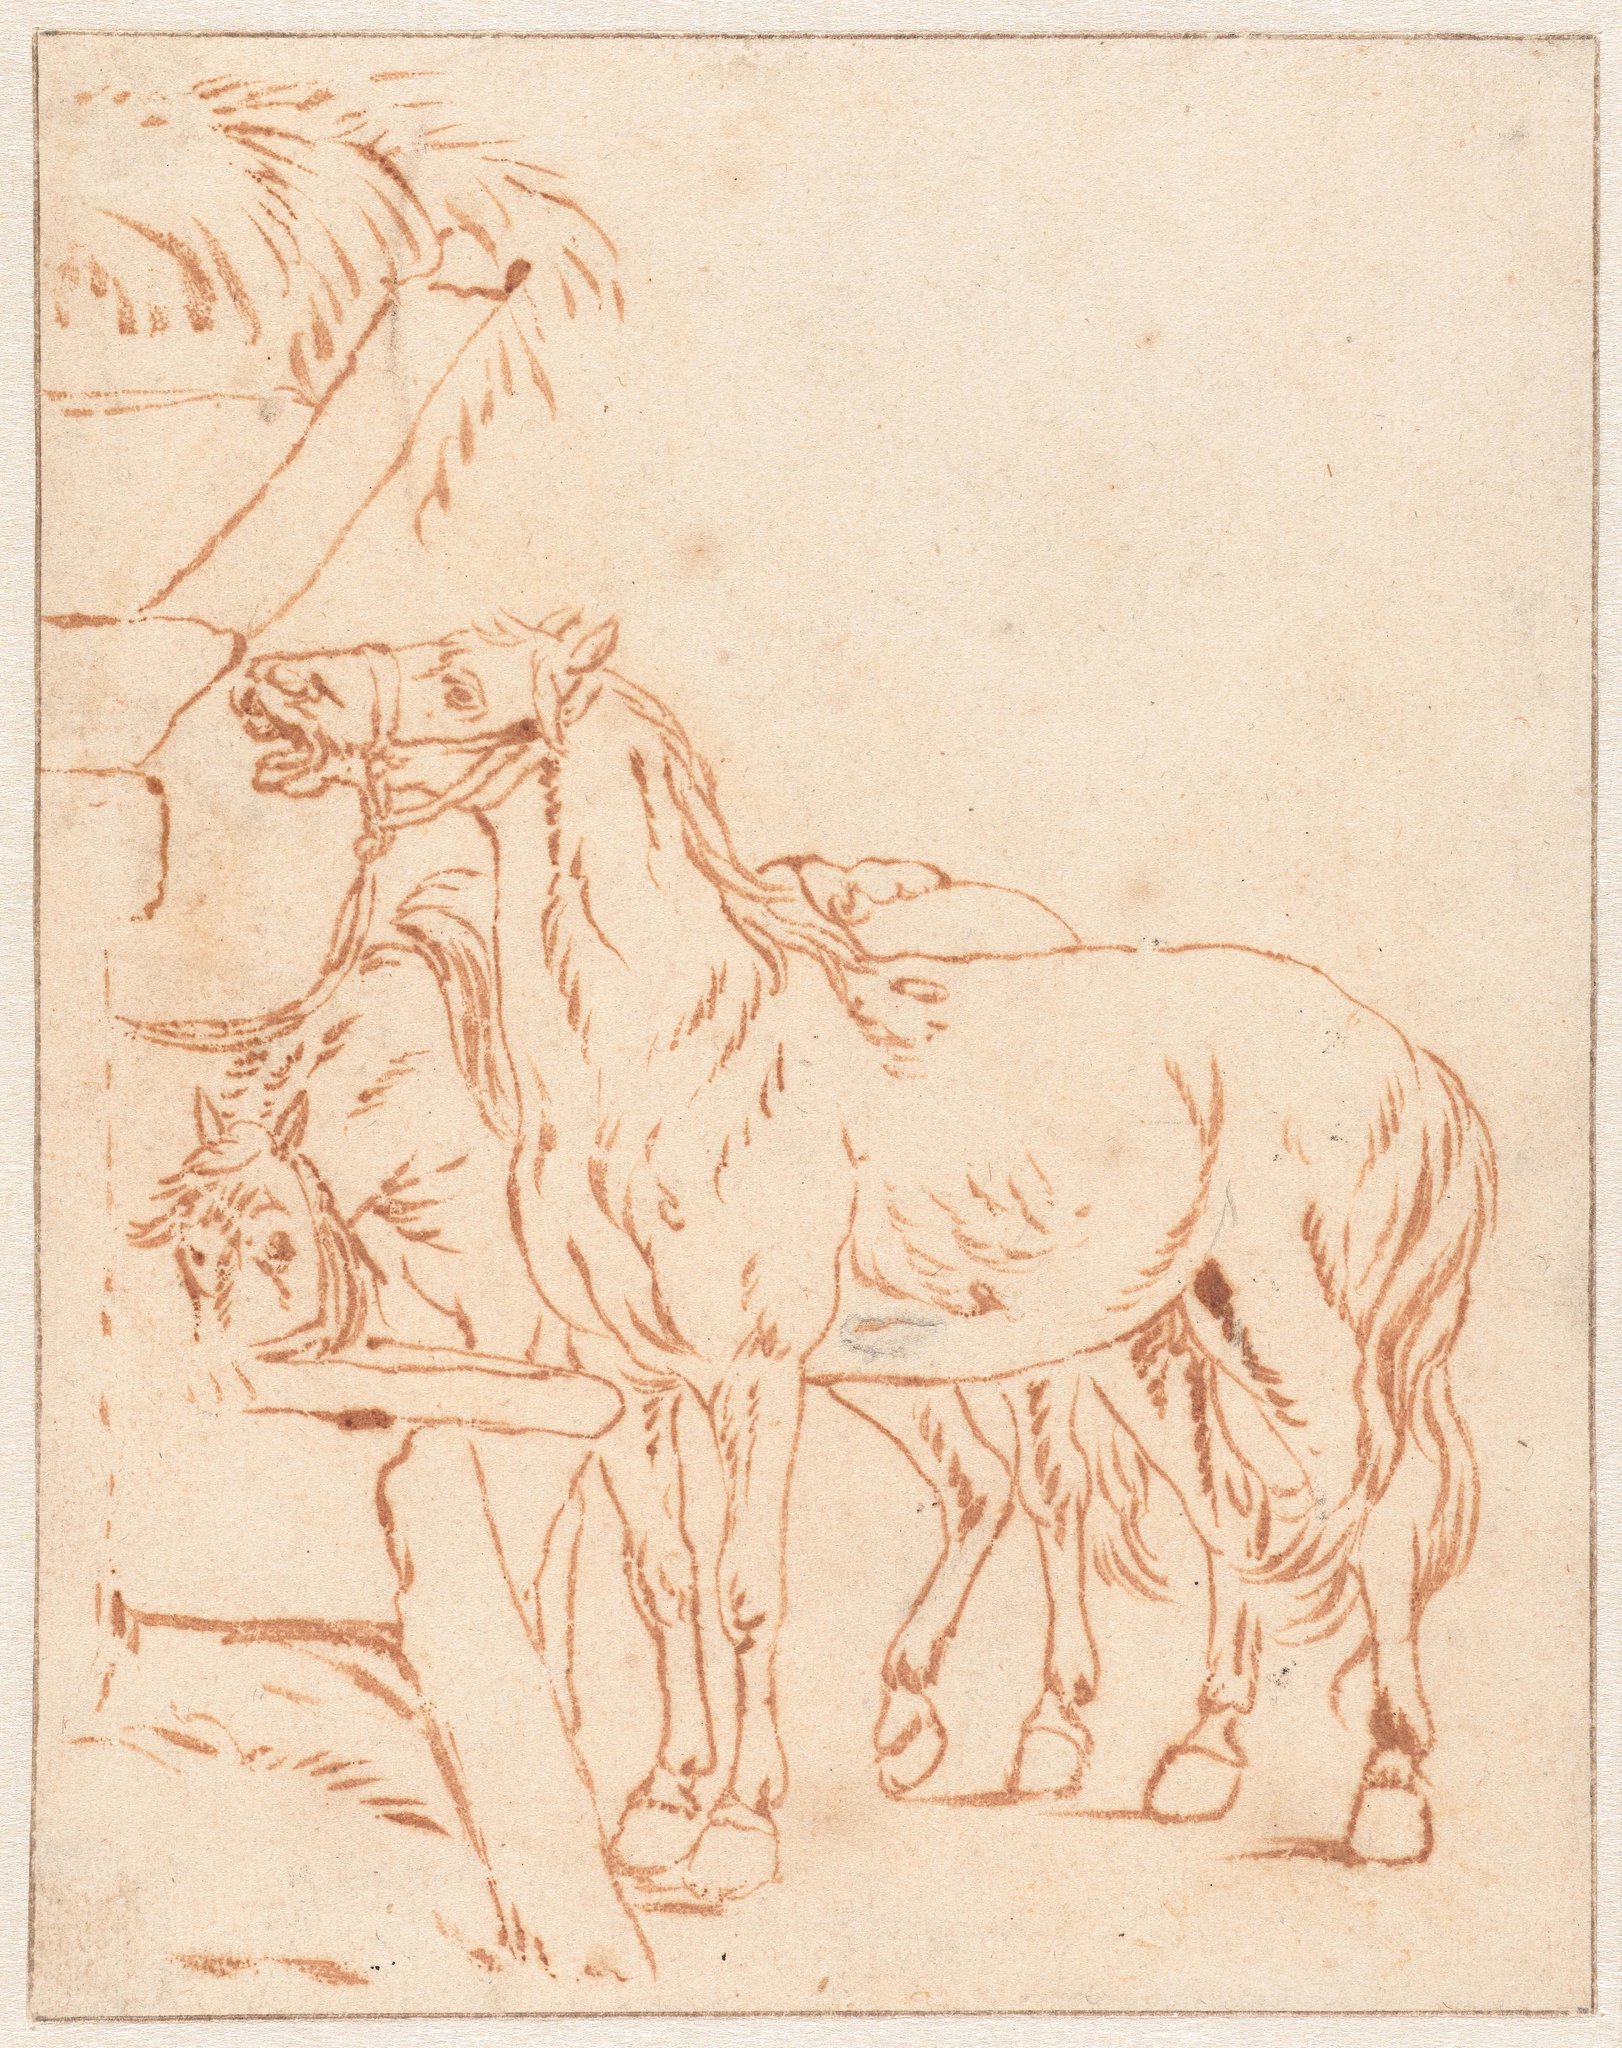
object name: drawing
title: Two Horses by a Trough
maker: Anonymous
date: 1625-1749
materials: chalk, paper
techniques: pouncing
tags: horse